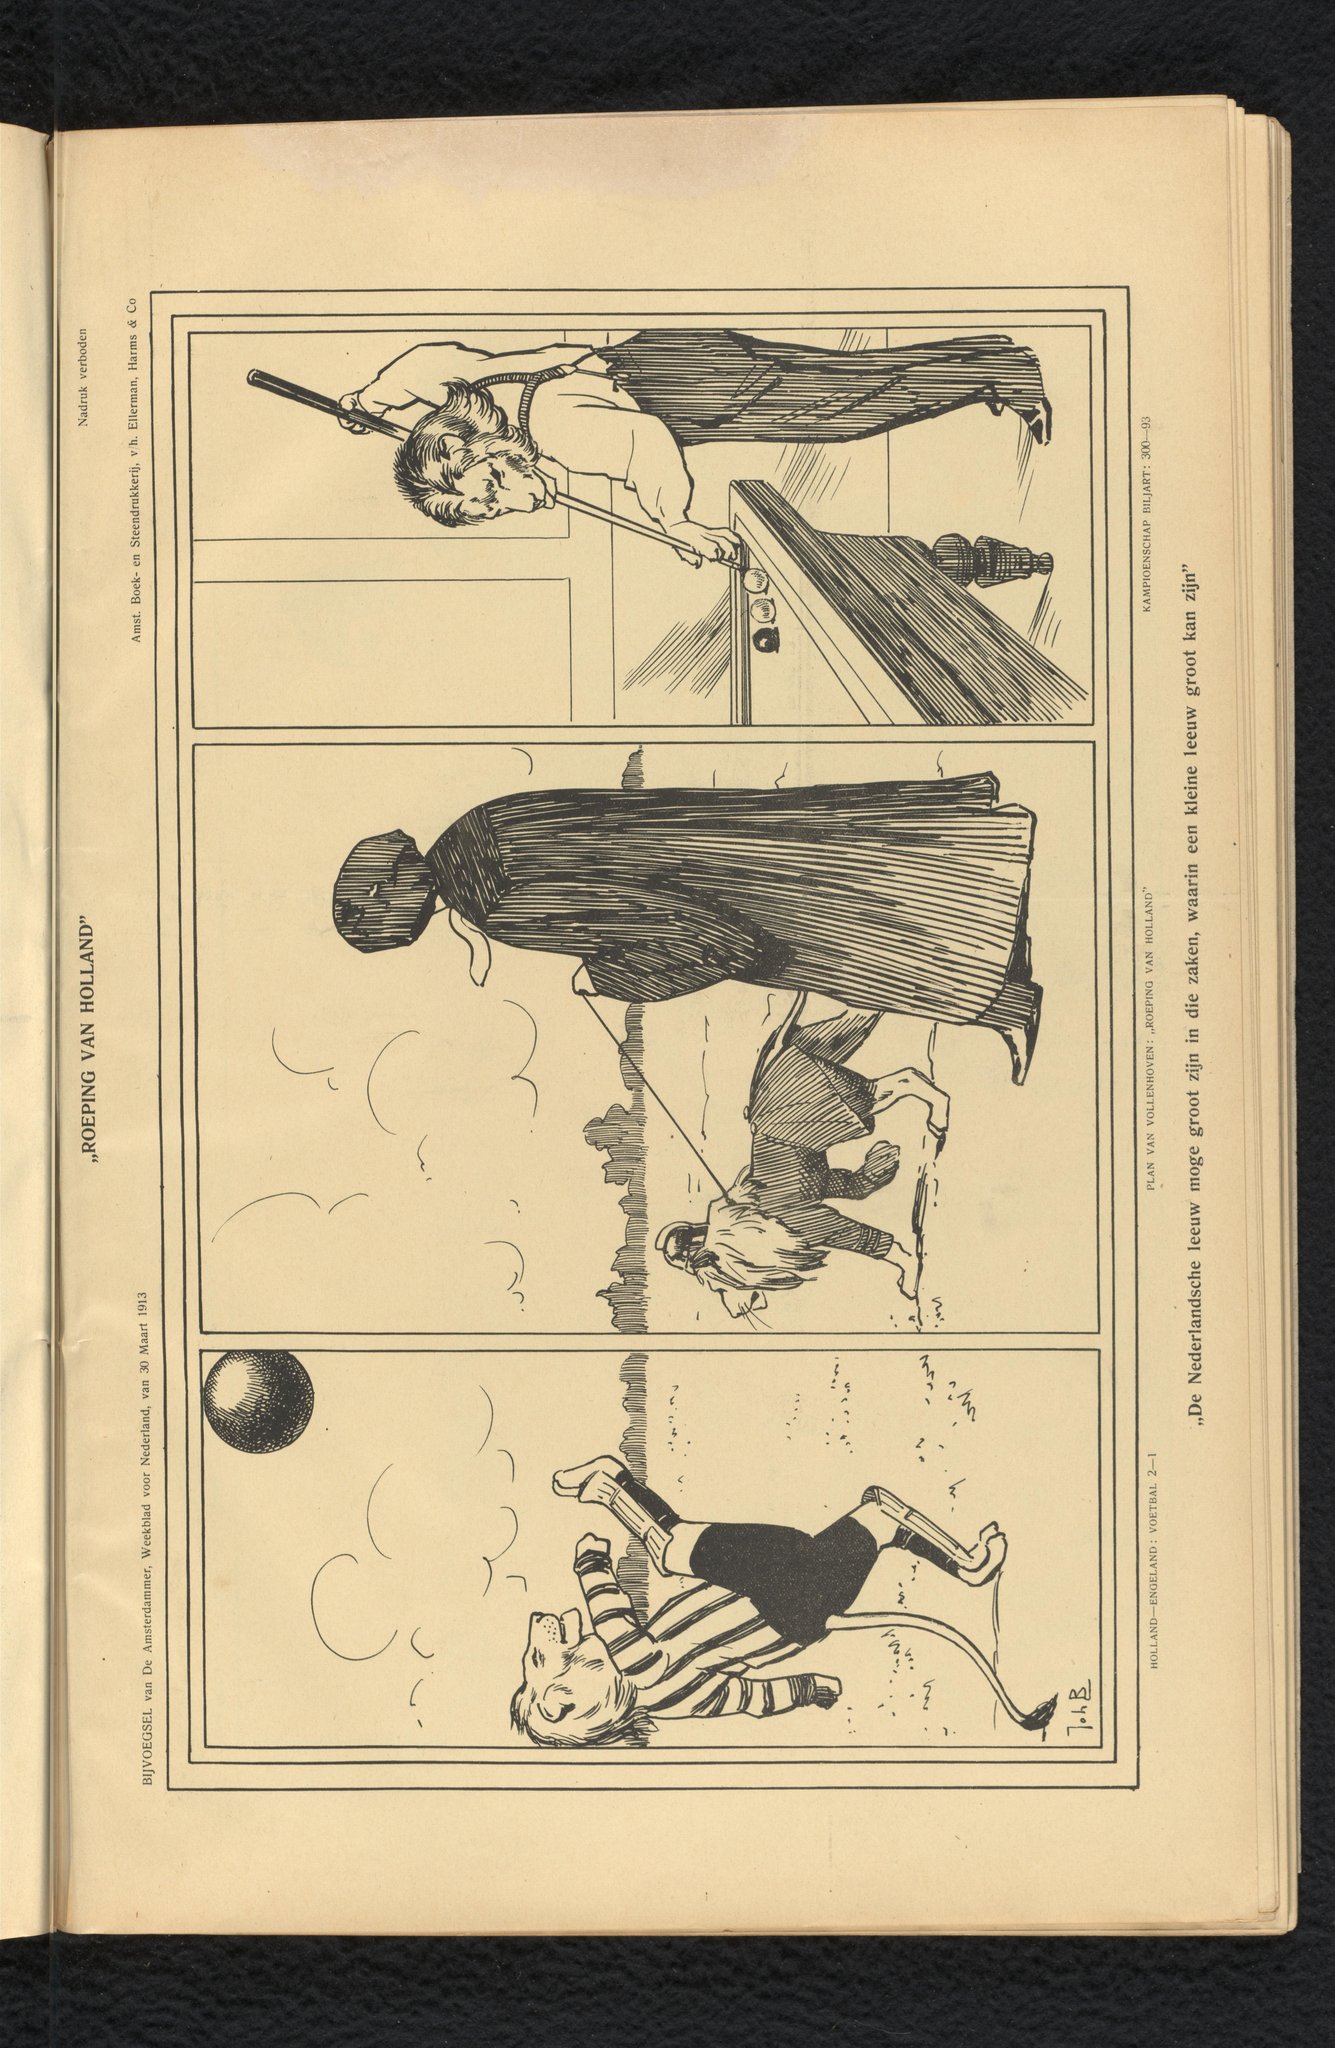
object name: cartoon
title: "Roeping van Holland"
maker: johan braakensiek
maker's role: draughtsman, print maker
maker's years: 1858-1940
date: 1913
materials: paper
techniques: lithograph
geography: netherlands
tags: dordrecht, leiden, billiards, personifications of countries, nations, states, districts, etc., soccer, football (early names: soule, choule, cholle), political caricatures and satires, police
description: Drie voorbeelden waarin de Nederlandse leeuw nog groot is: het voetballen (2-1 winst op Engeland), de pleit door Cornelis van Vollenhoven voor Nederland als internationale politiemacht en Nederland als kampioen biljarten.